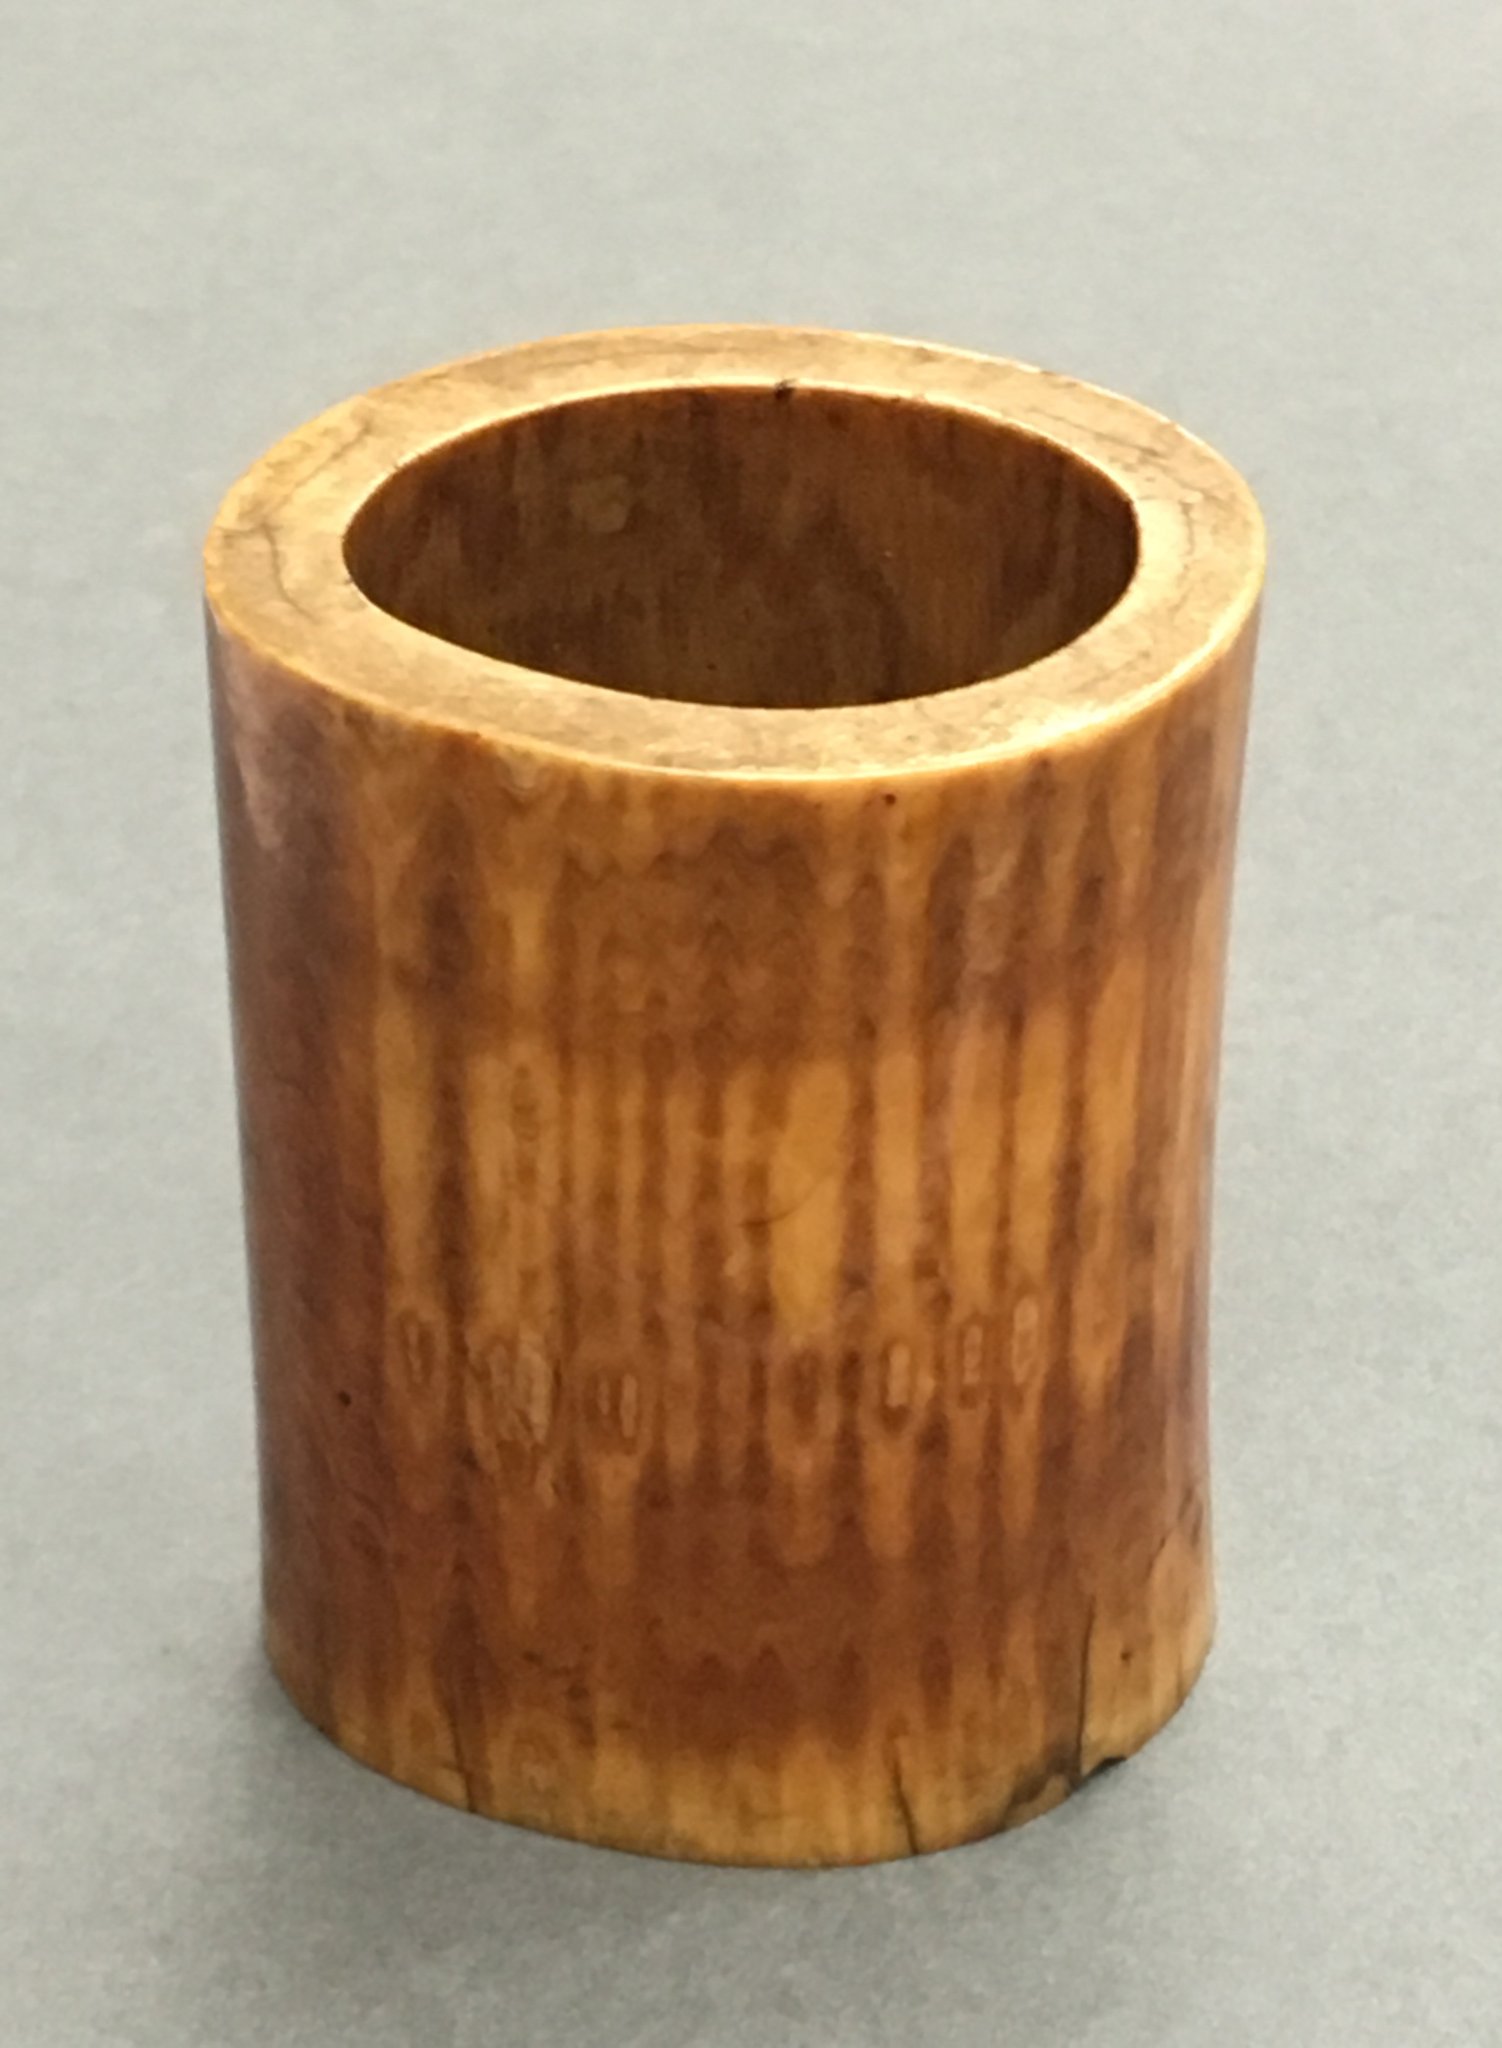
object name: brush pot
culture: chinese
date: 1867-2000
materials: ivory